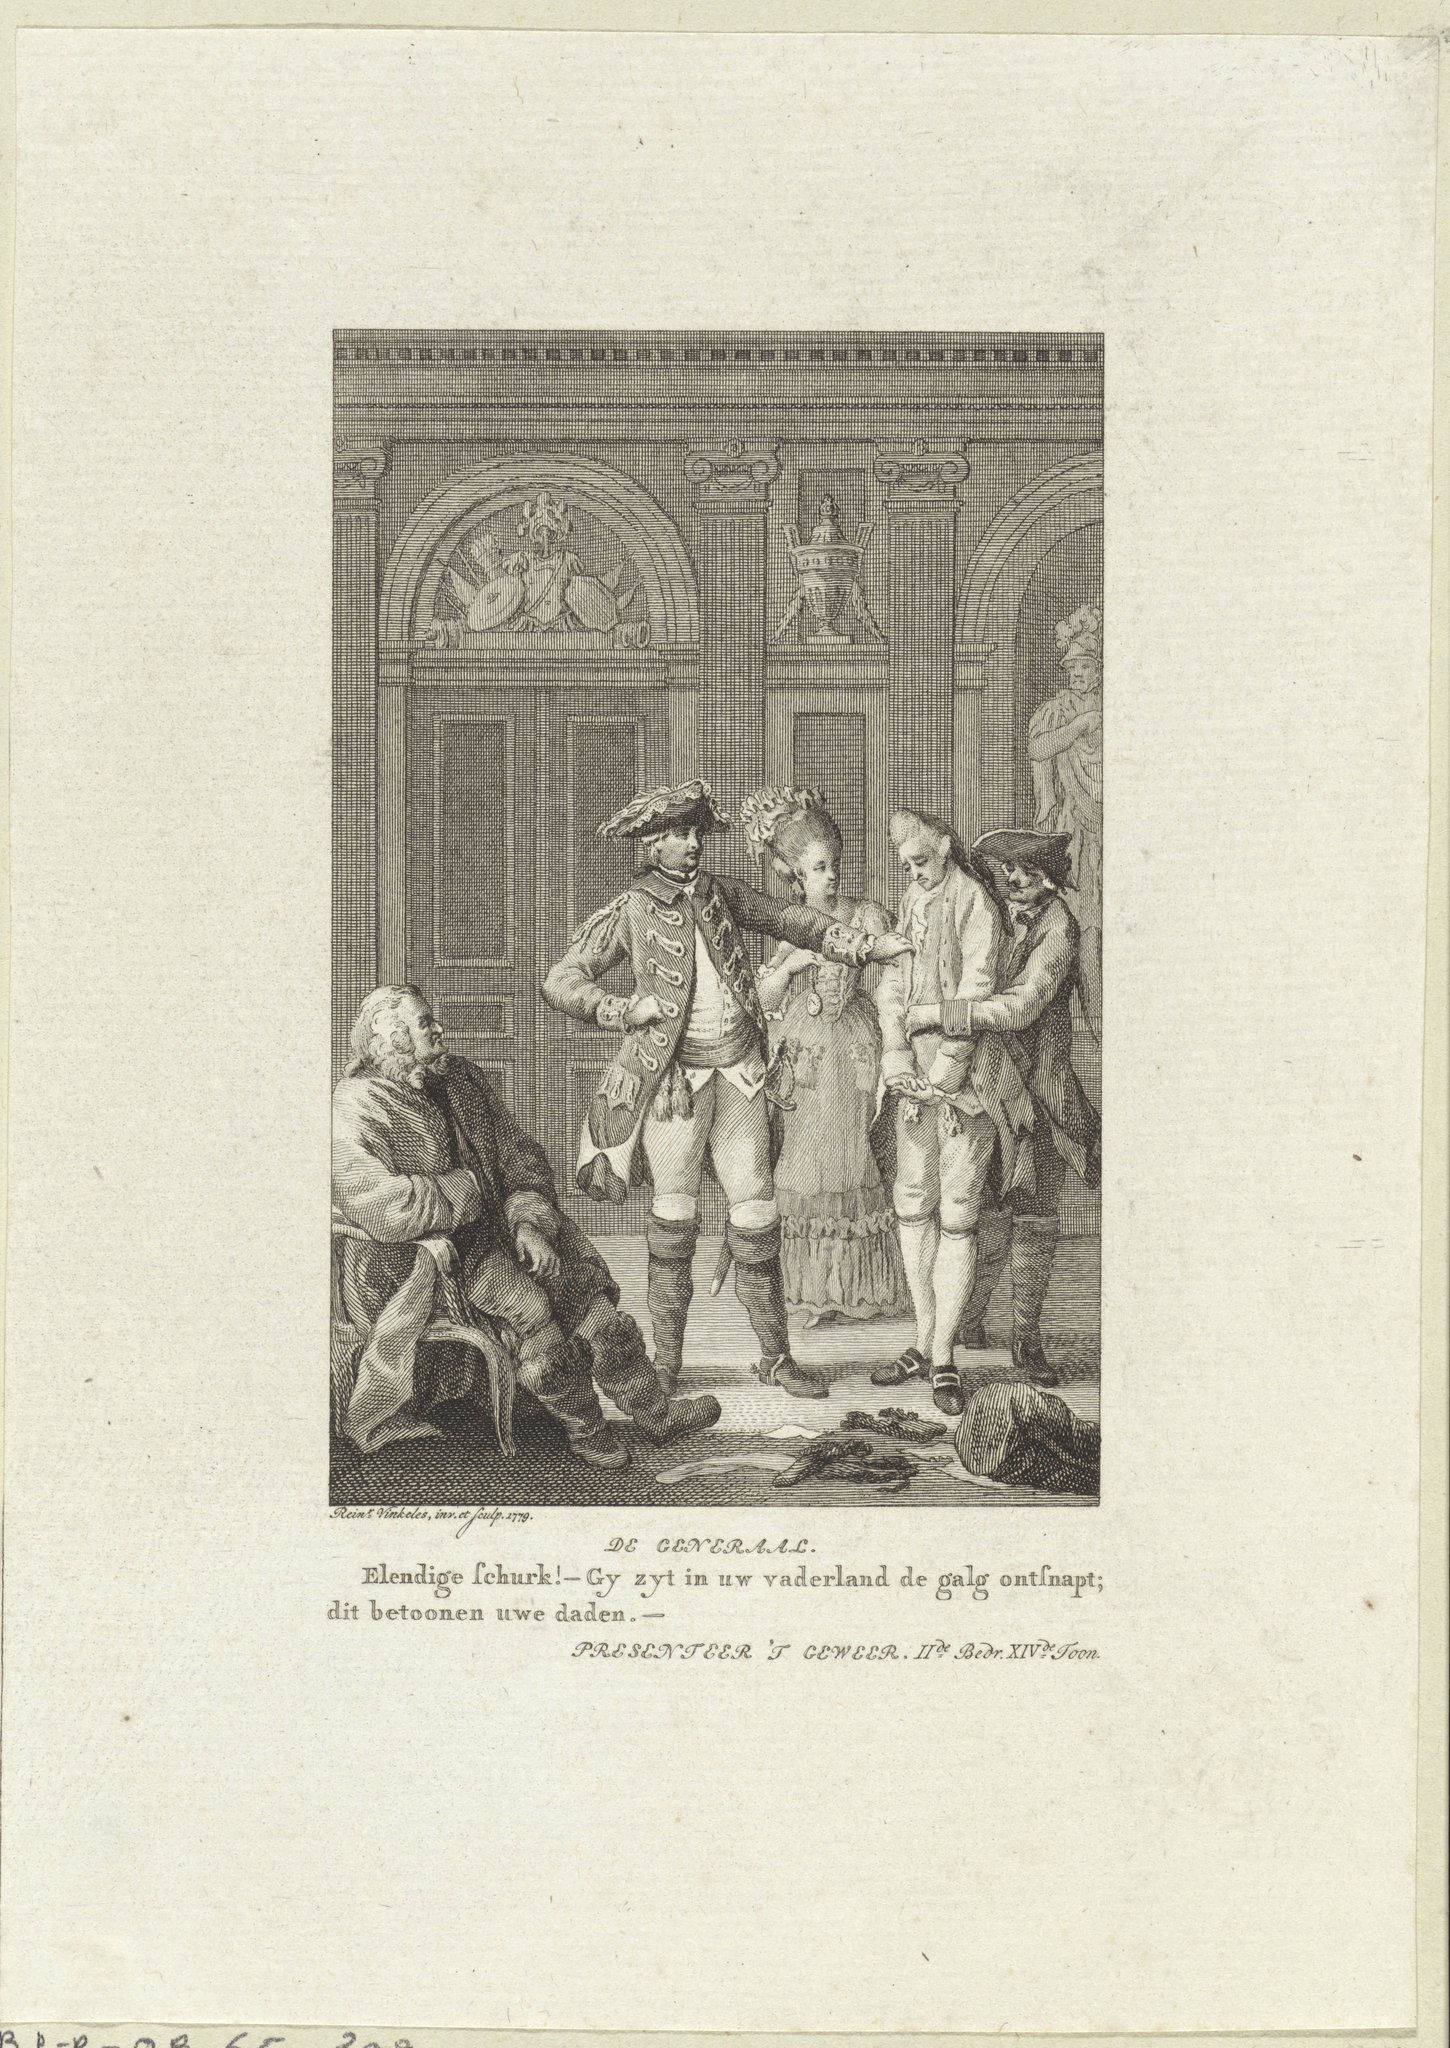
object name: print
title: In een vertrek wordt een schurk ontmanteld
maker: reinier vinkeles (i)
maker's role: draughtsman, print maker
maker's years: 1741-1816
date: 1779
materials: paper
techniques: engraving, etching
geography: amsterdam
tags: disguise, watch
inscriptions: collector's mark: Lugt 240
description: Illustratie die mogelijk is gebruikt in: Müller, Johann Heinrich Friedrich. Presenteer 't geweer!. Amsteldam: erven van Pieter Meĳer en Gerrit Warnars, 1789.